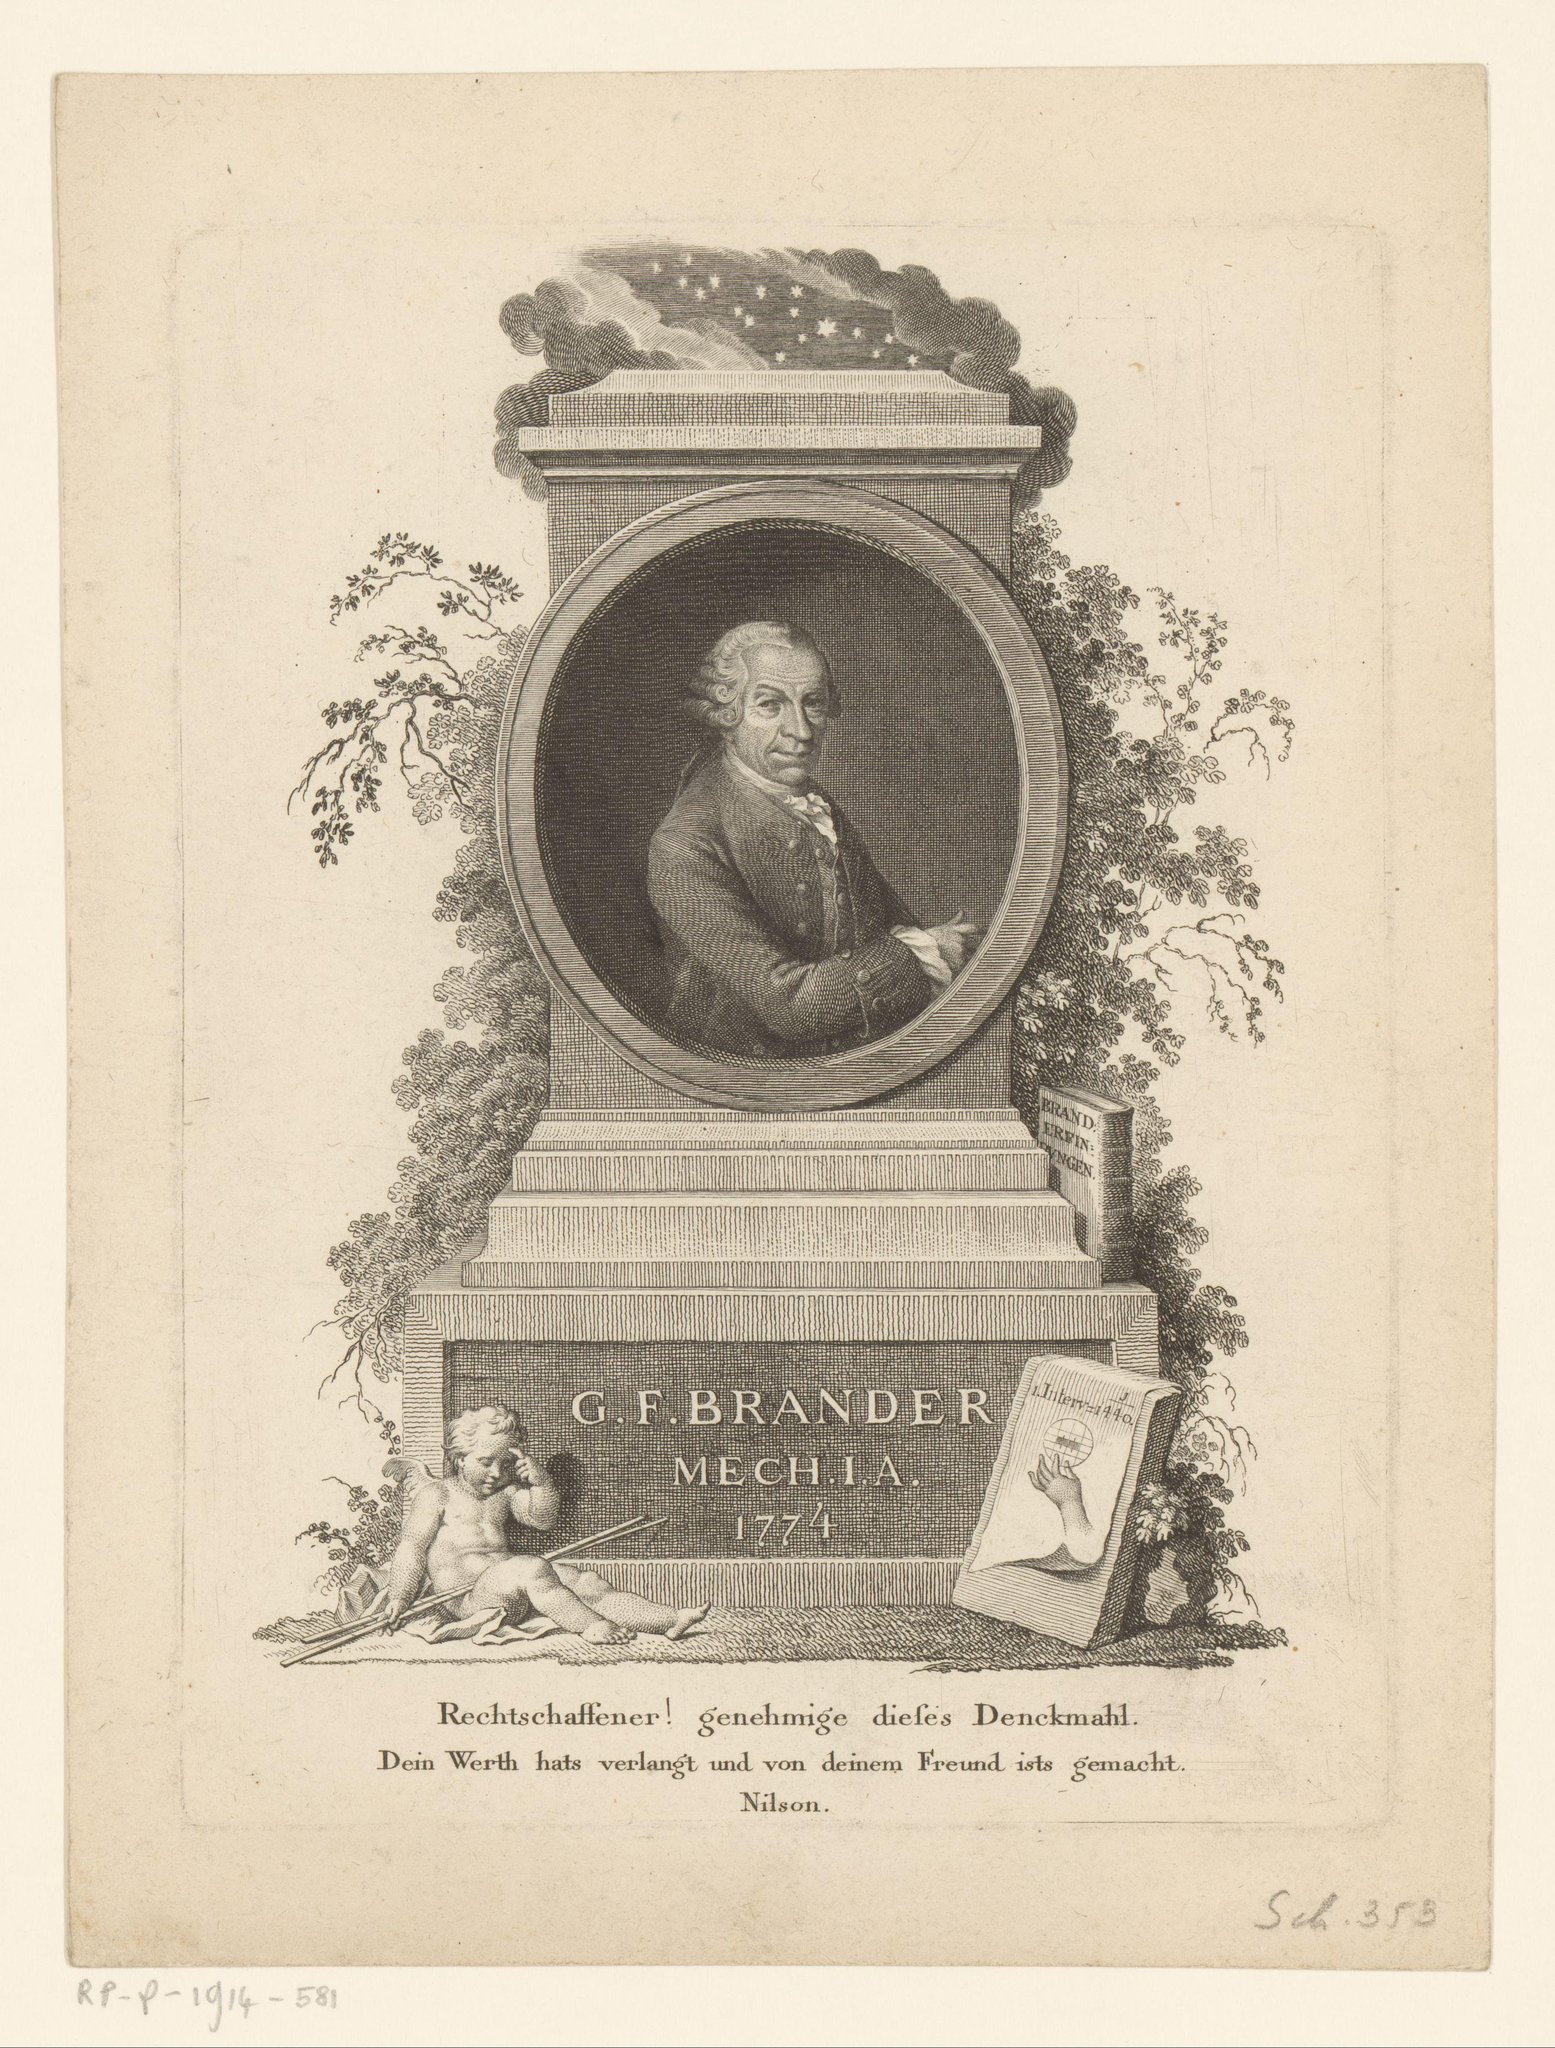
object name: print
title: Portret van Georg Friedrich Brander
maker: johann esaias nilson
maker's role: draughtsman, print maker, publisher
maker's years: 1721-1788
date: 1774-1788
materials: paper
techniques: engraving, etching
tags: instrument maker, historical persons, mathematics, astrology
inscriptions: collector's mark: Lugt 2228